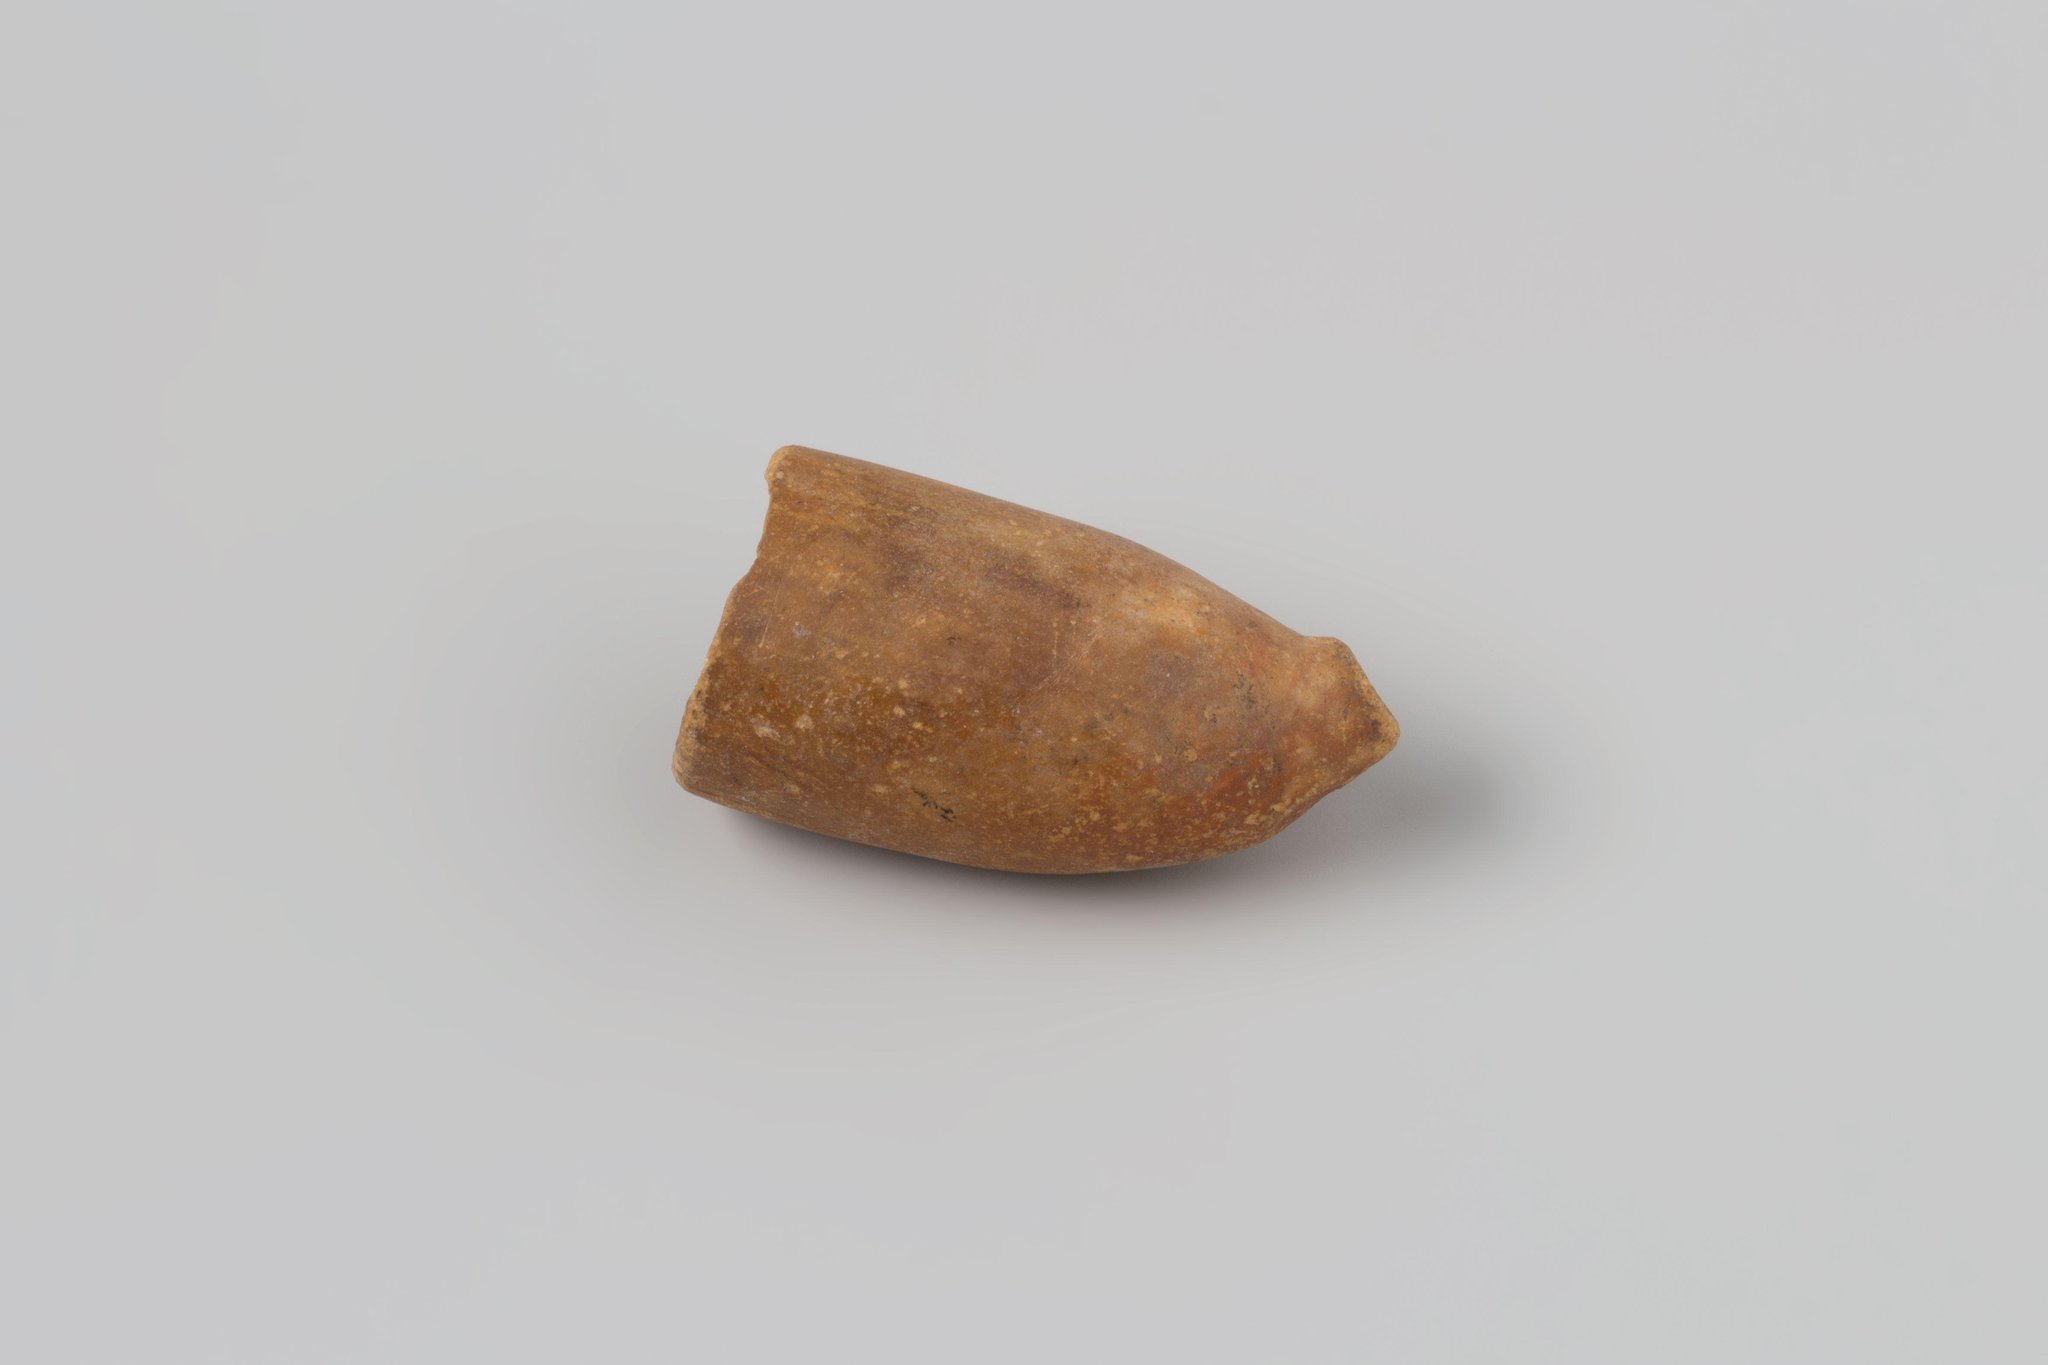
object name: pipe bowl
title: Pijpenkop uit het wrak van de Oost-Indiëvaarder Hollandia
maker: Anonymous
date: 1700-1743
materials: clay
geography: netherlands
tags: verenigde oostindische compagnie, hollandia (schip), annet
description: Pipe, bowl without heel: stamped decoration; fragment, imprint: 1 dot.